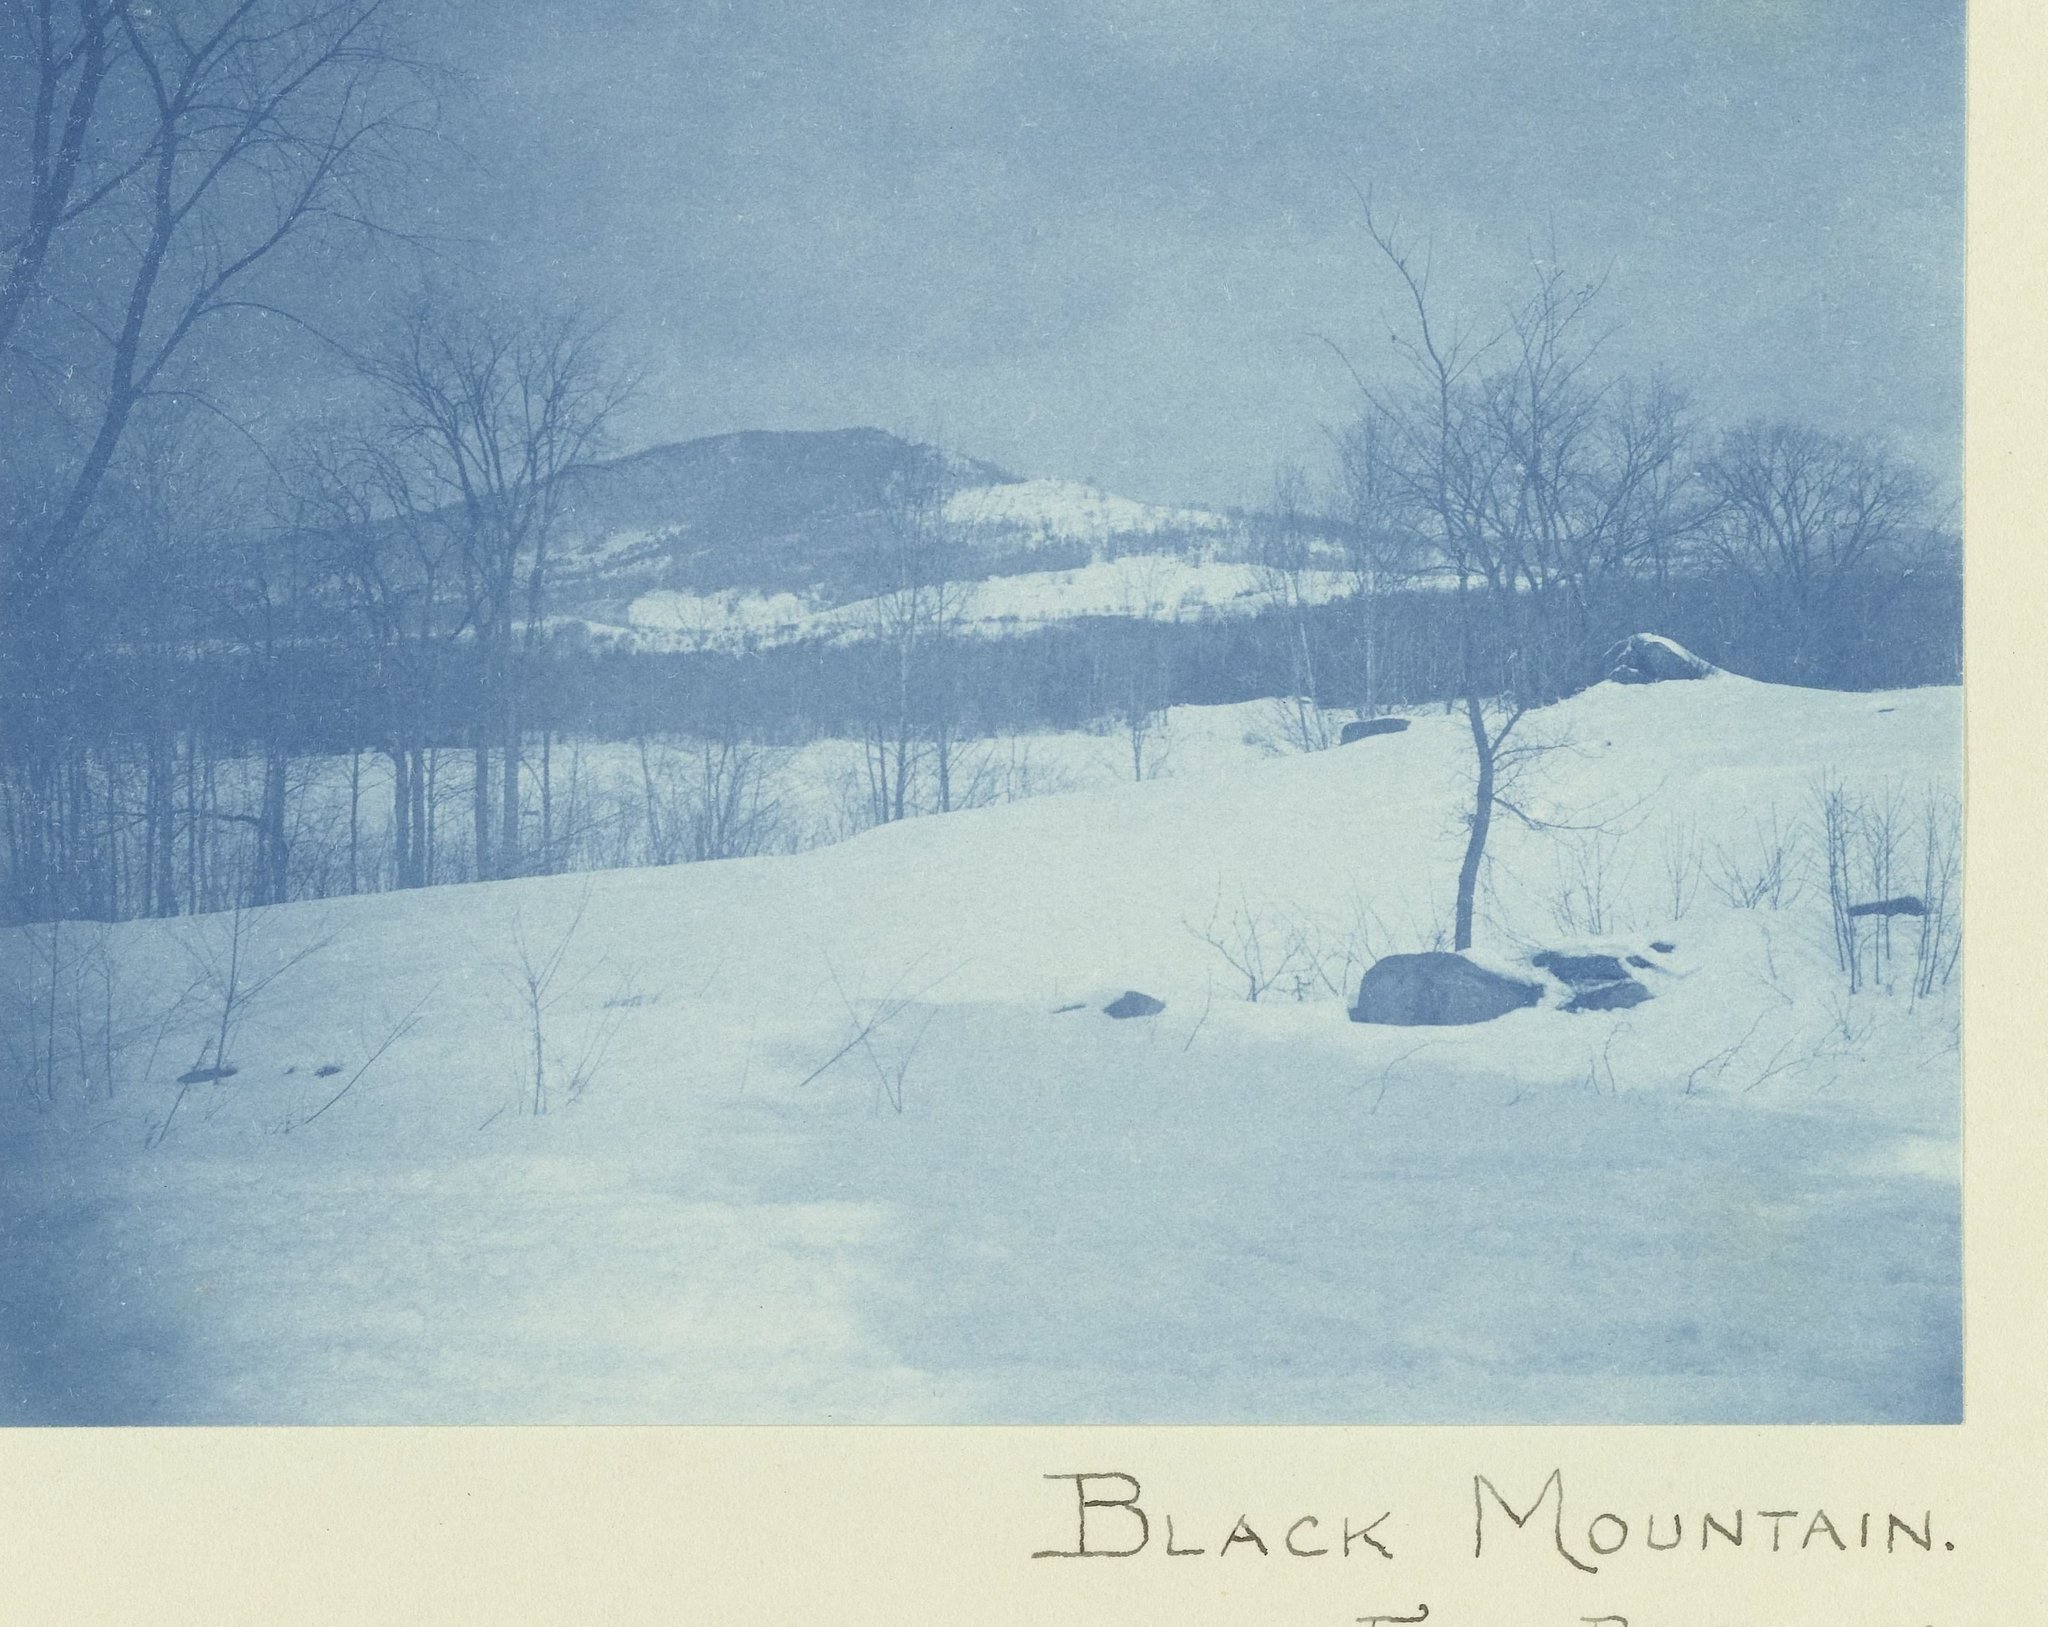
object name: photograph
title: Landschap in de sneeuw: Black Mountain, gezien vanaf een weg nabij Gale's, NH, Verenigde Staten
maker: charlotte m. endicott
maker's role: fotograaf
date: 1899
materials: photographic support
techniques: cyanotype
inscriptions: title: ‘BLACK MOUNTAIN. / FROM ROAD, NEAR GALE'S / FEB. 19. 1899’